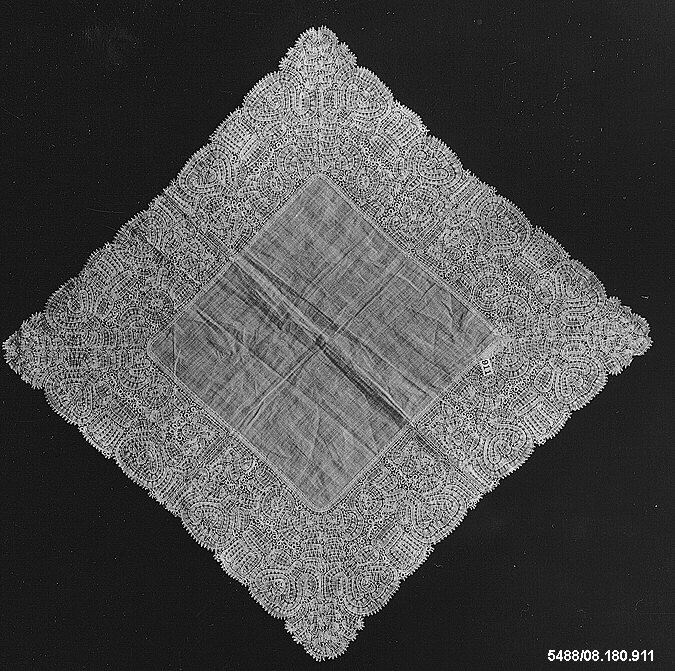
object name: handkerchief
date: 1801-1900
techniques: lace